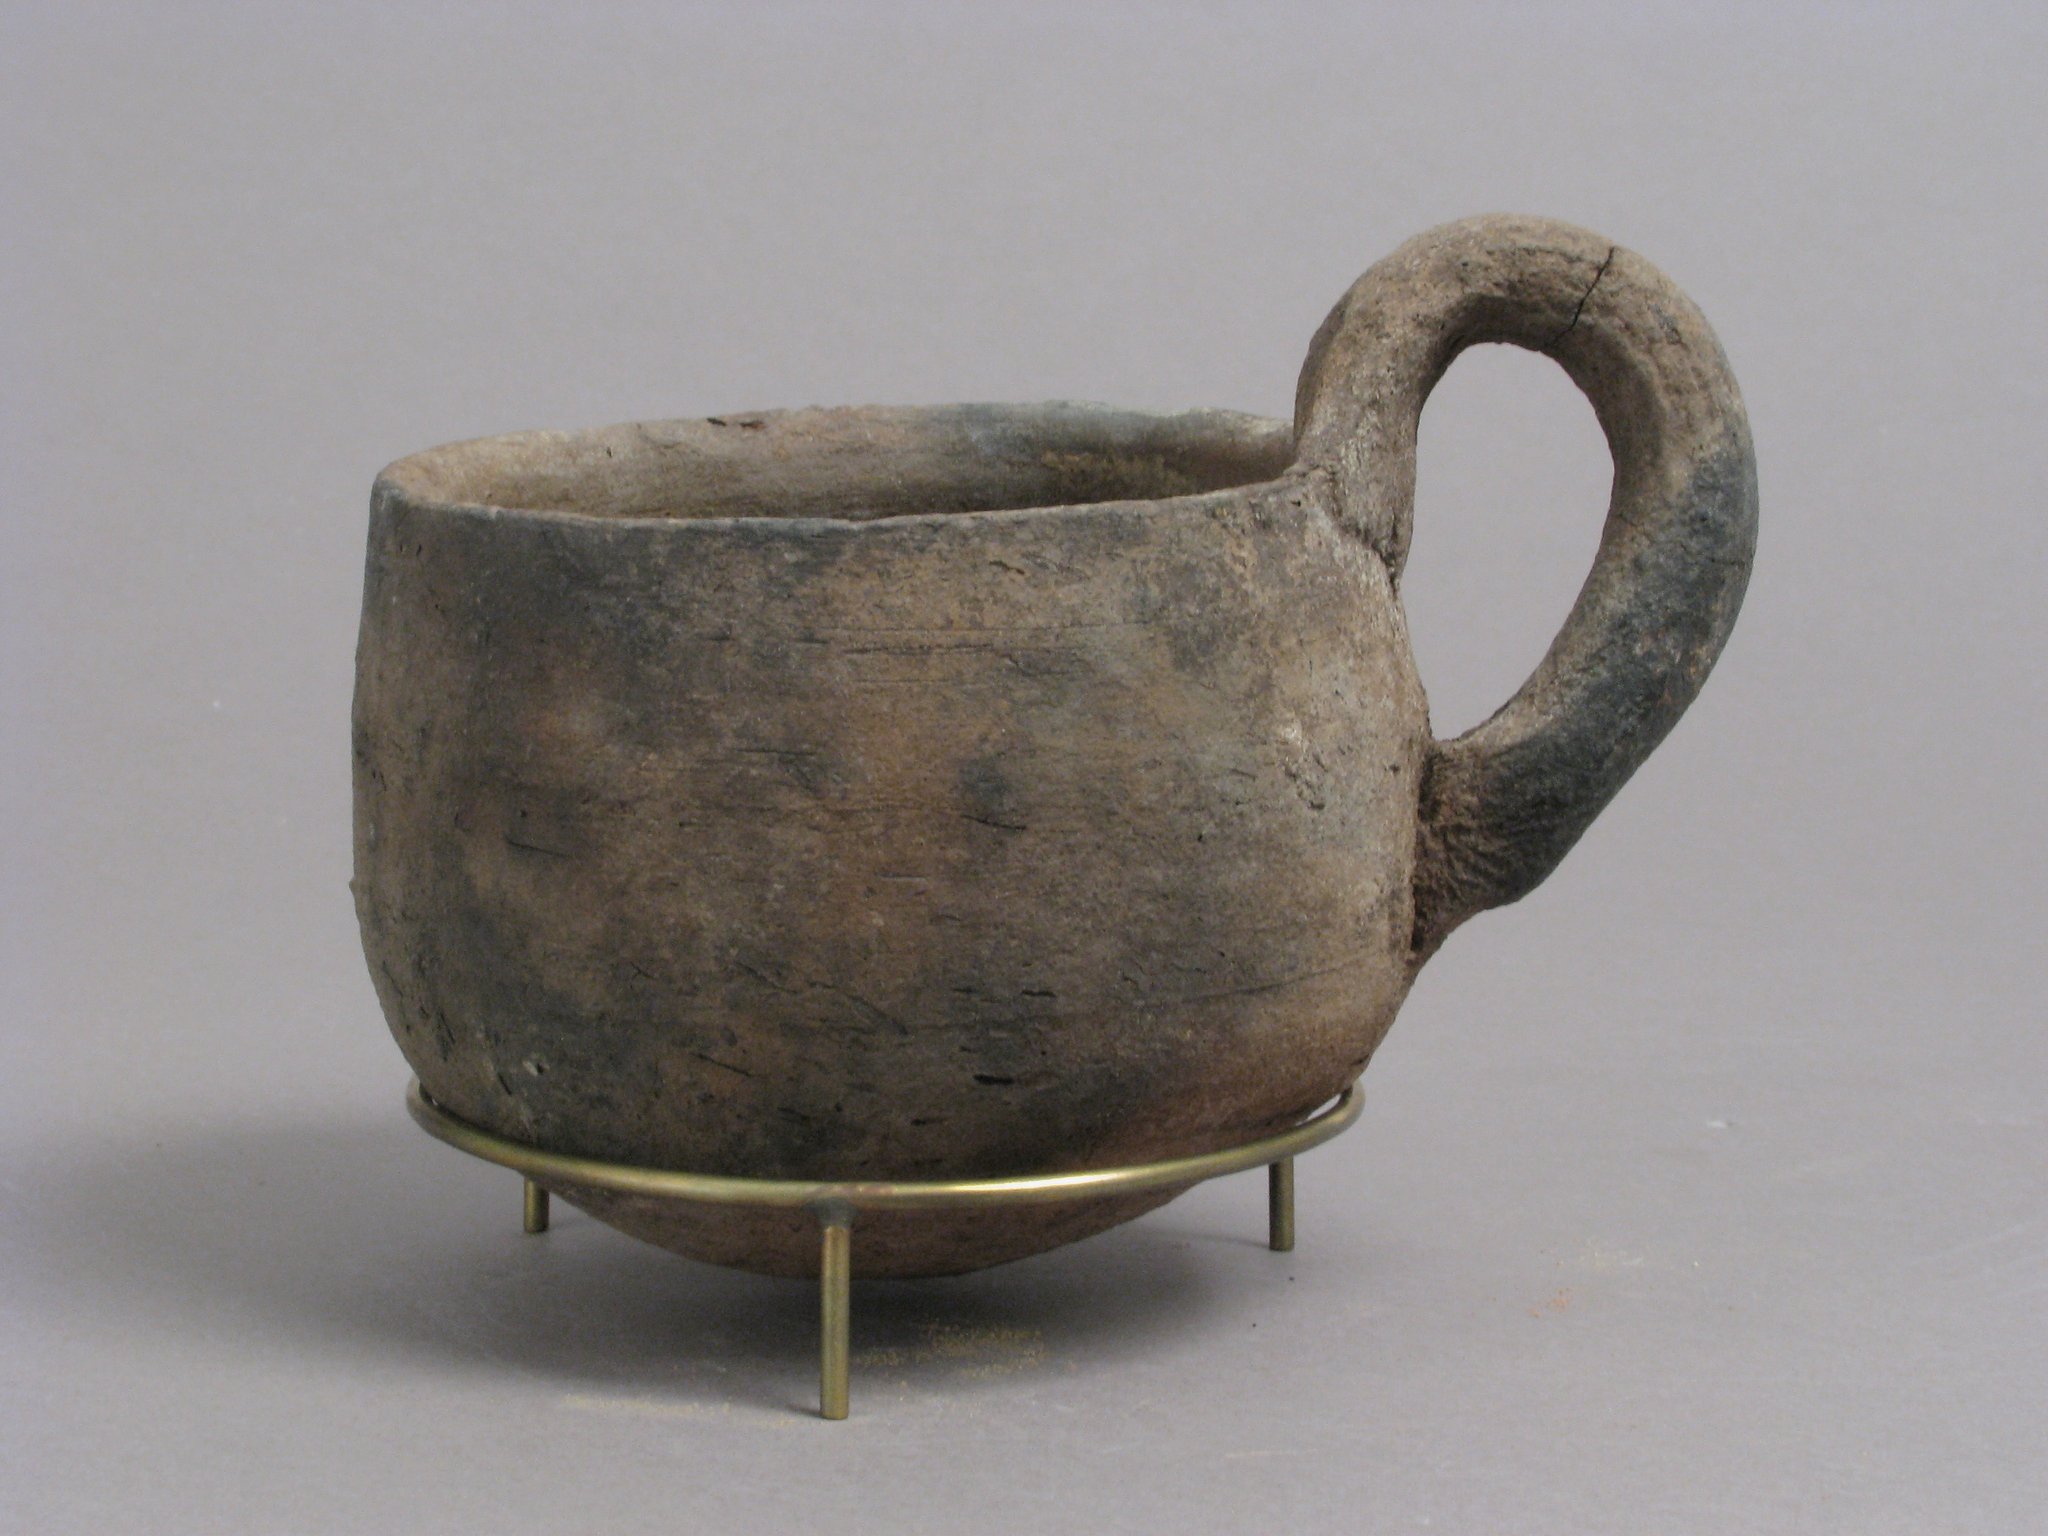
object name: cup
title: Cup with Handle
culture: coptic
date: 301-700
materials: earthenware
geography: egypt